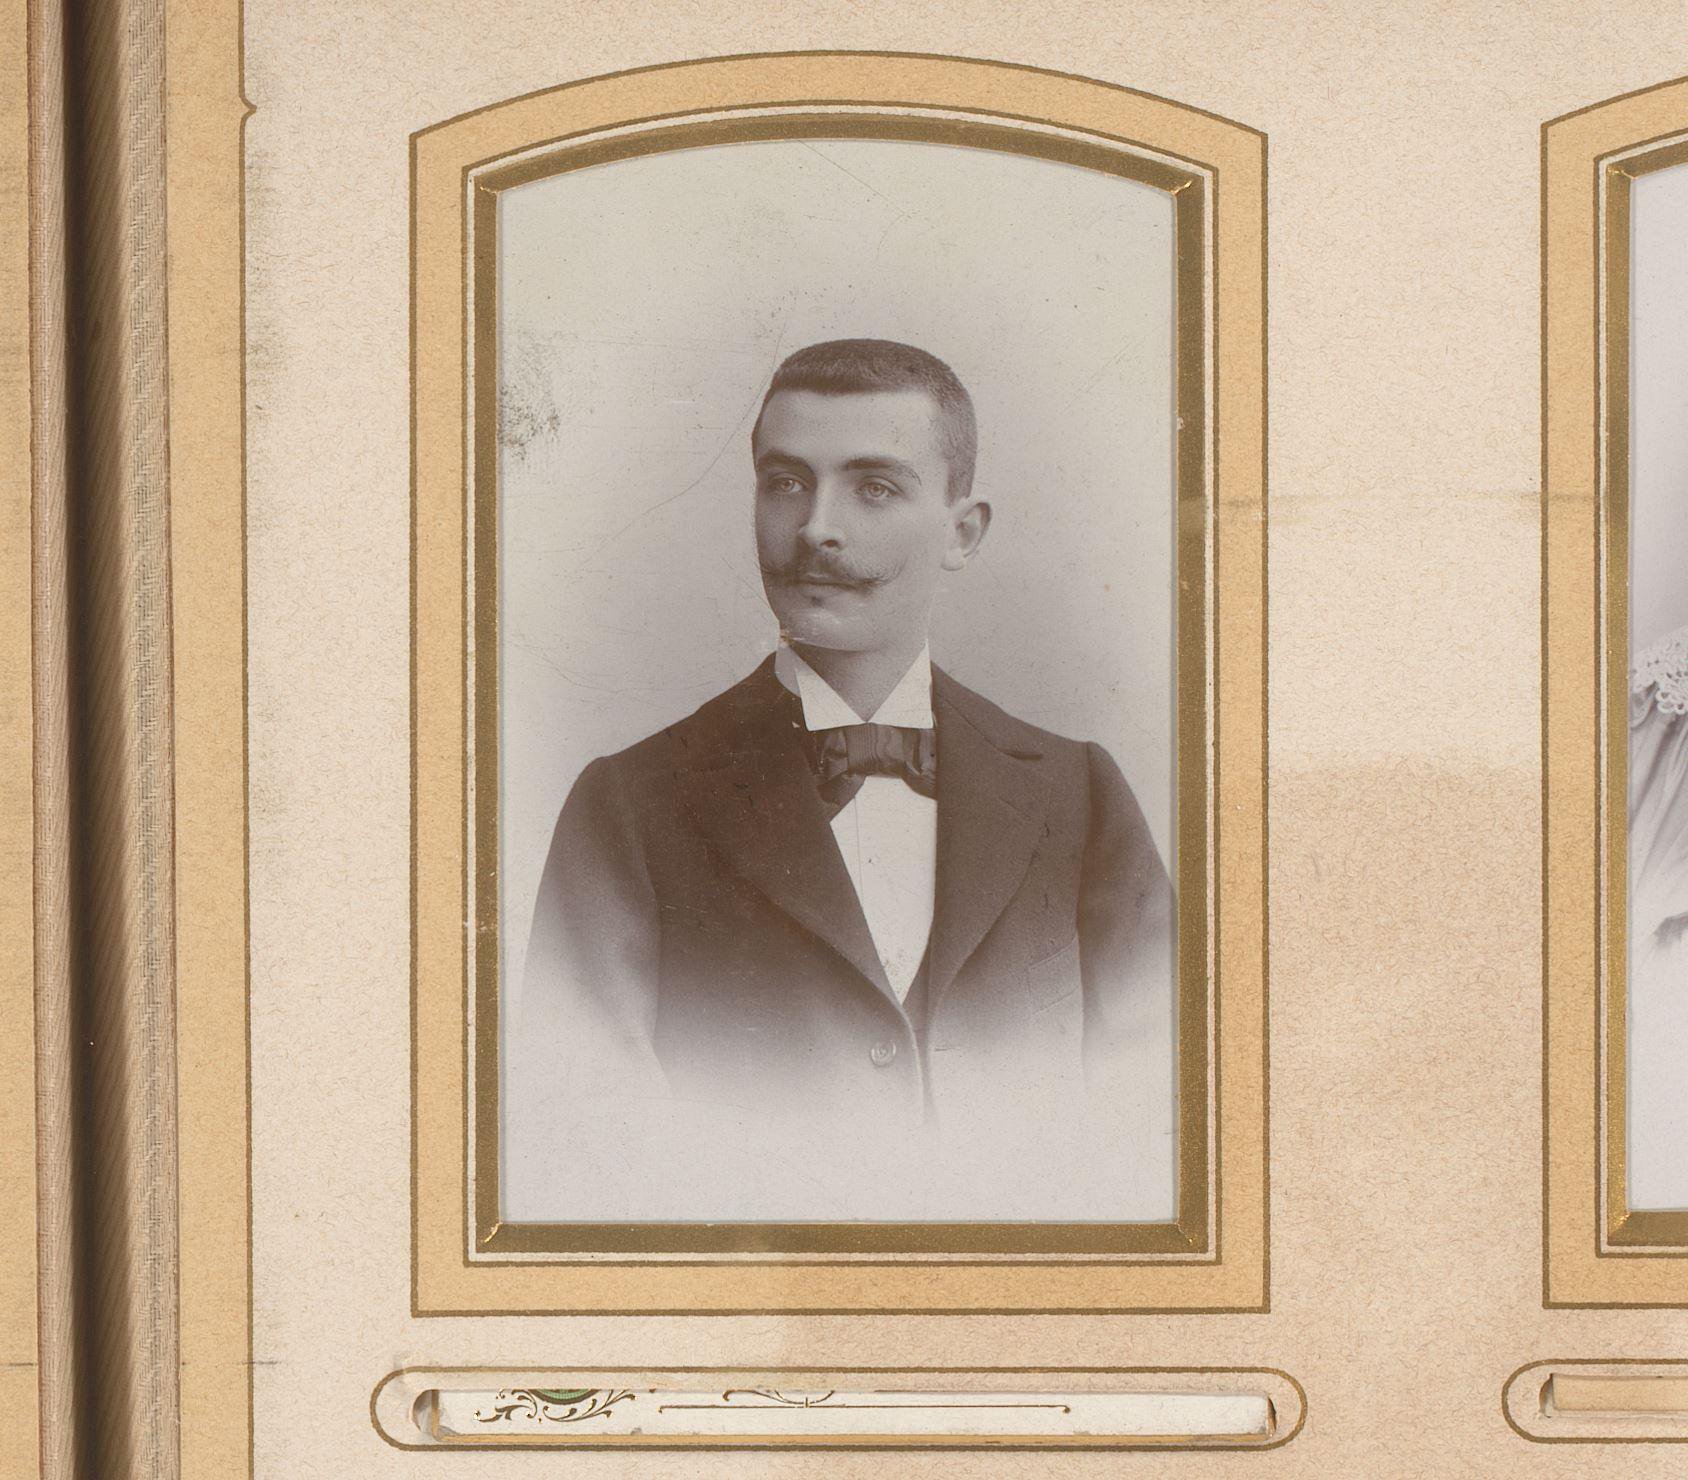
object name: photograph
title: Portret van een man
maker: georges michel (fotograaf)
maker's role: fotograaf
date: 1870-1900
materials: cardboard, photographic support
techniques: collodion silver print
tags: adult man, historical persons